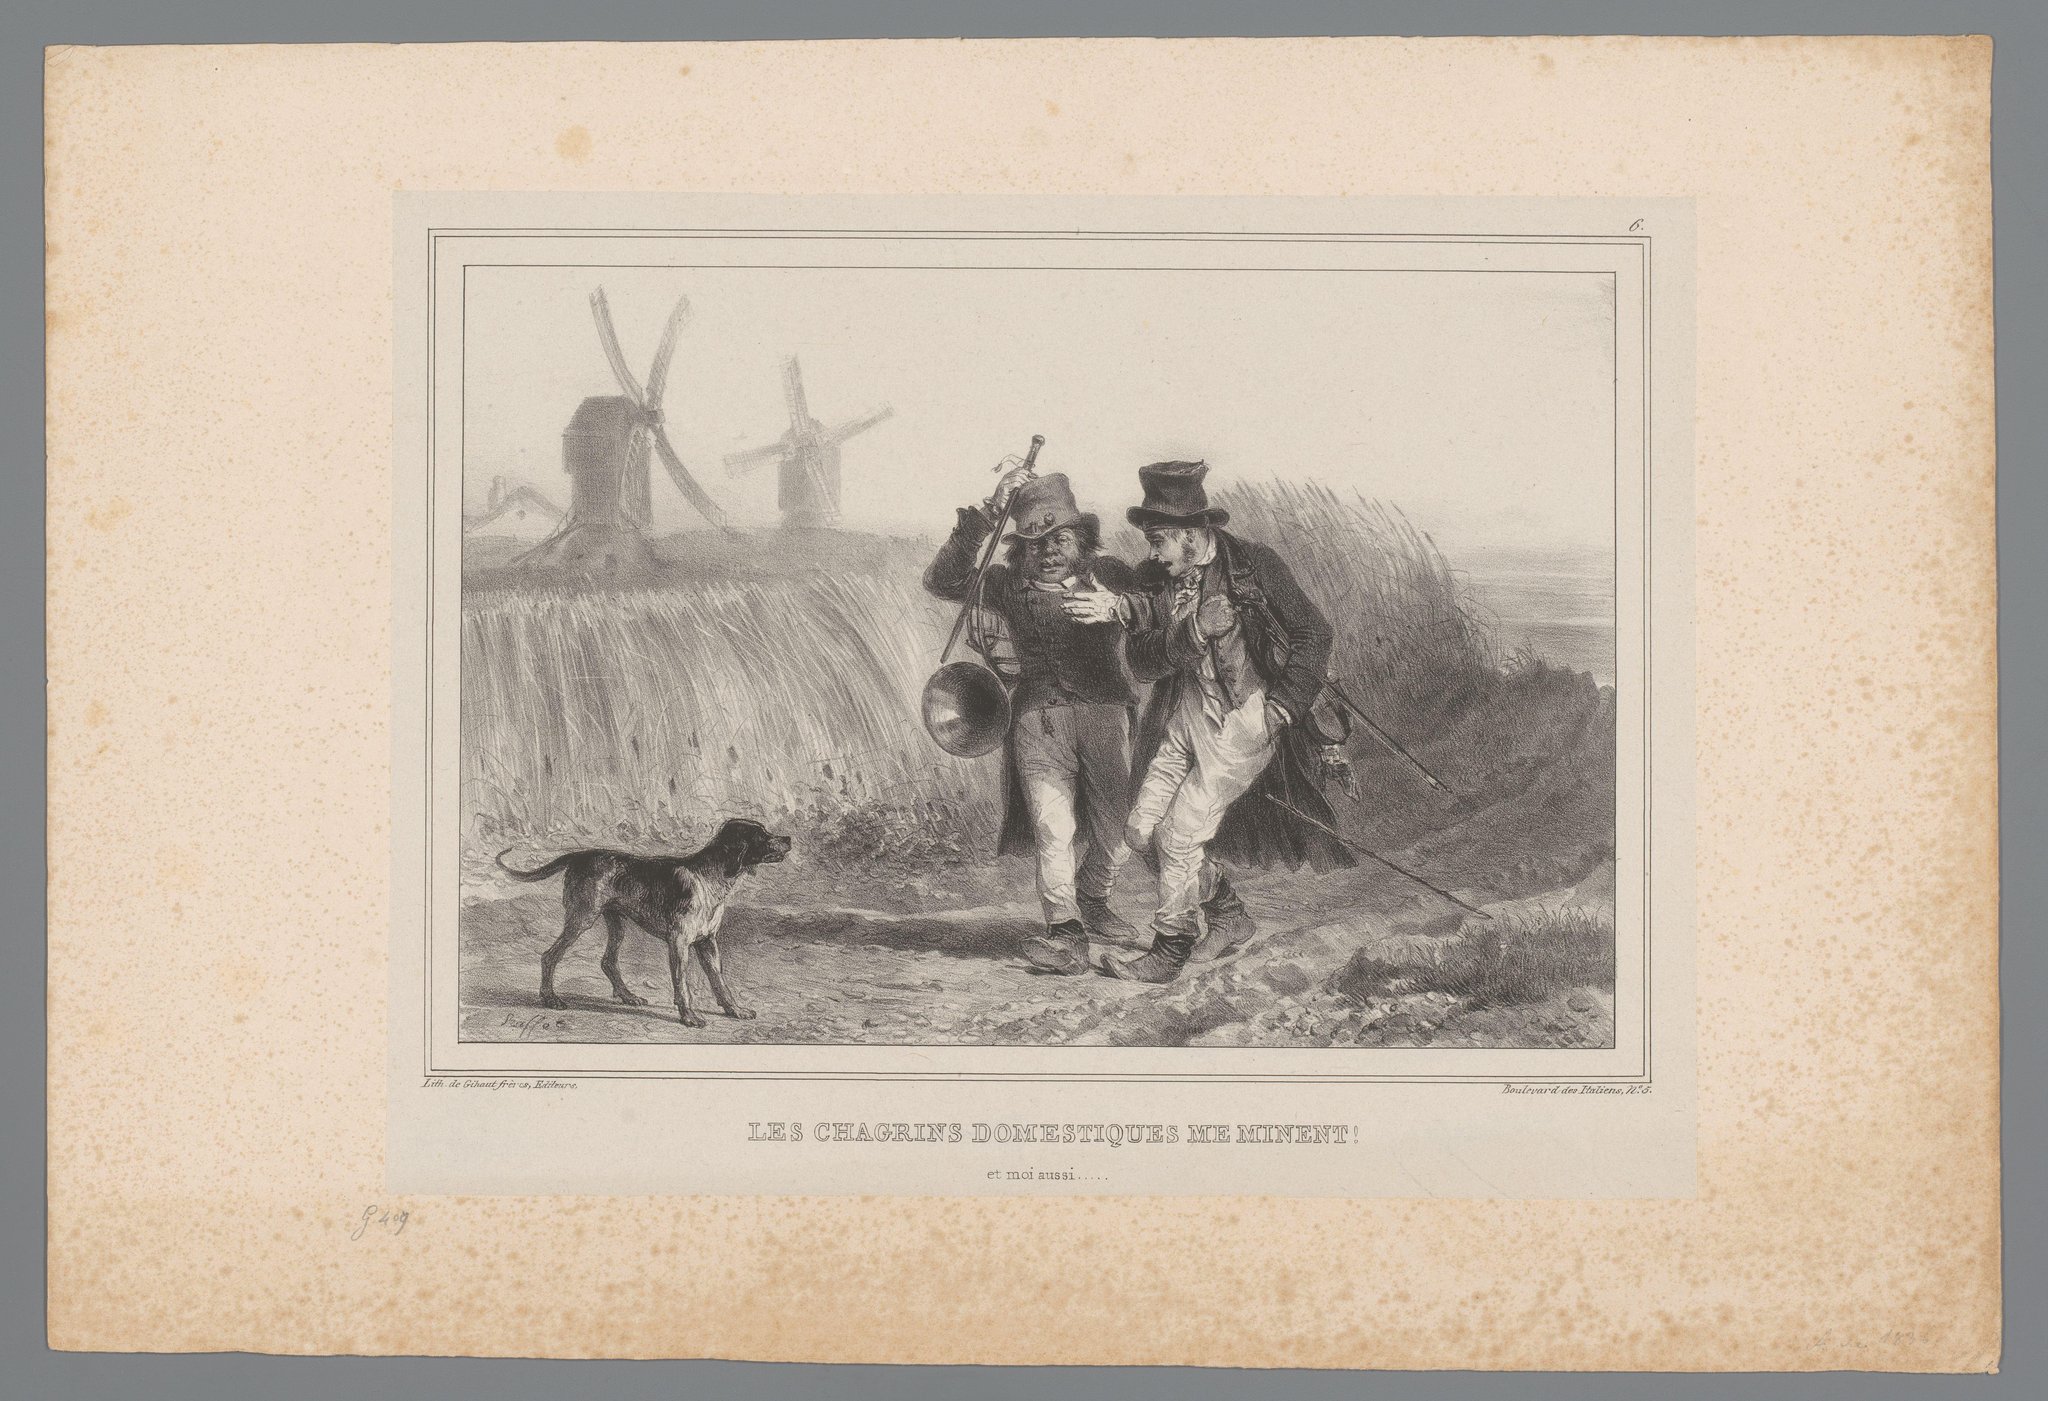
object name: print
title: Les chagrins domestiques me minent!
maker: denis auguste marie raffet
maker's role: draughtsman, print maker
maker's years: 1804-1860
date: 1836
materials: paper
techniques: lithograph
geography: paris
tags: musician, horn, trumpet, cornet, trombone, tuba, violin, fiddle, windmill in landscape, dog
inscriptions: collector's mark: Lugt 964